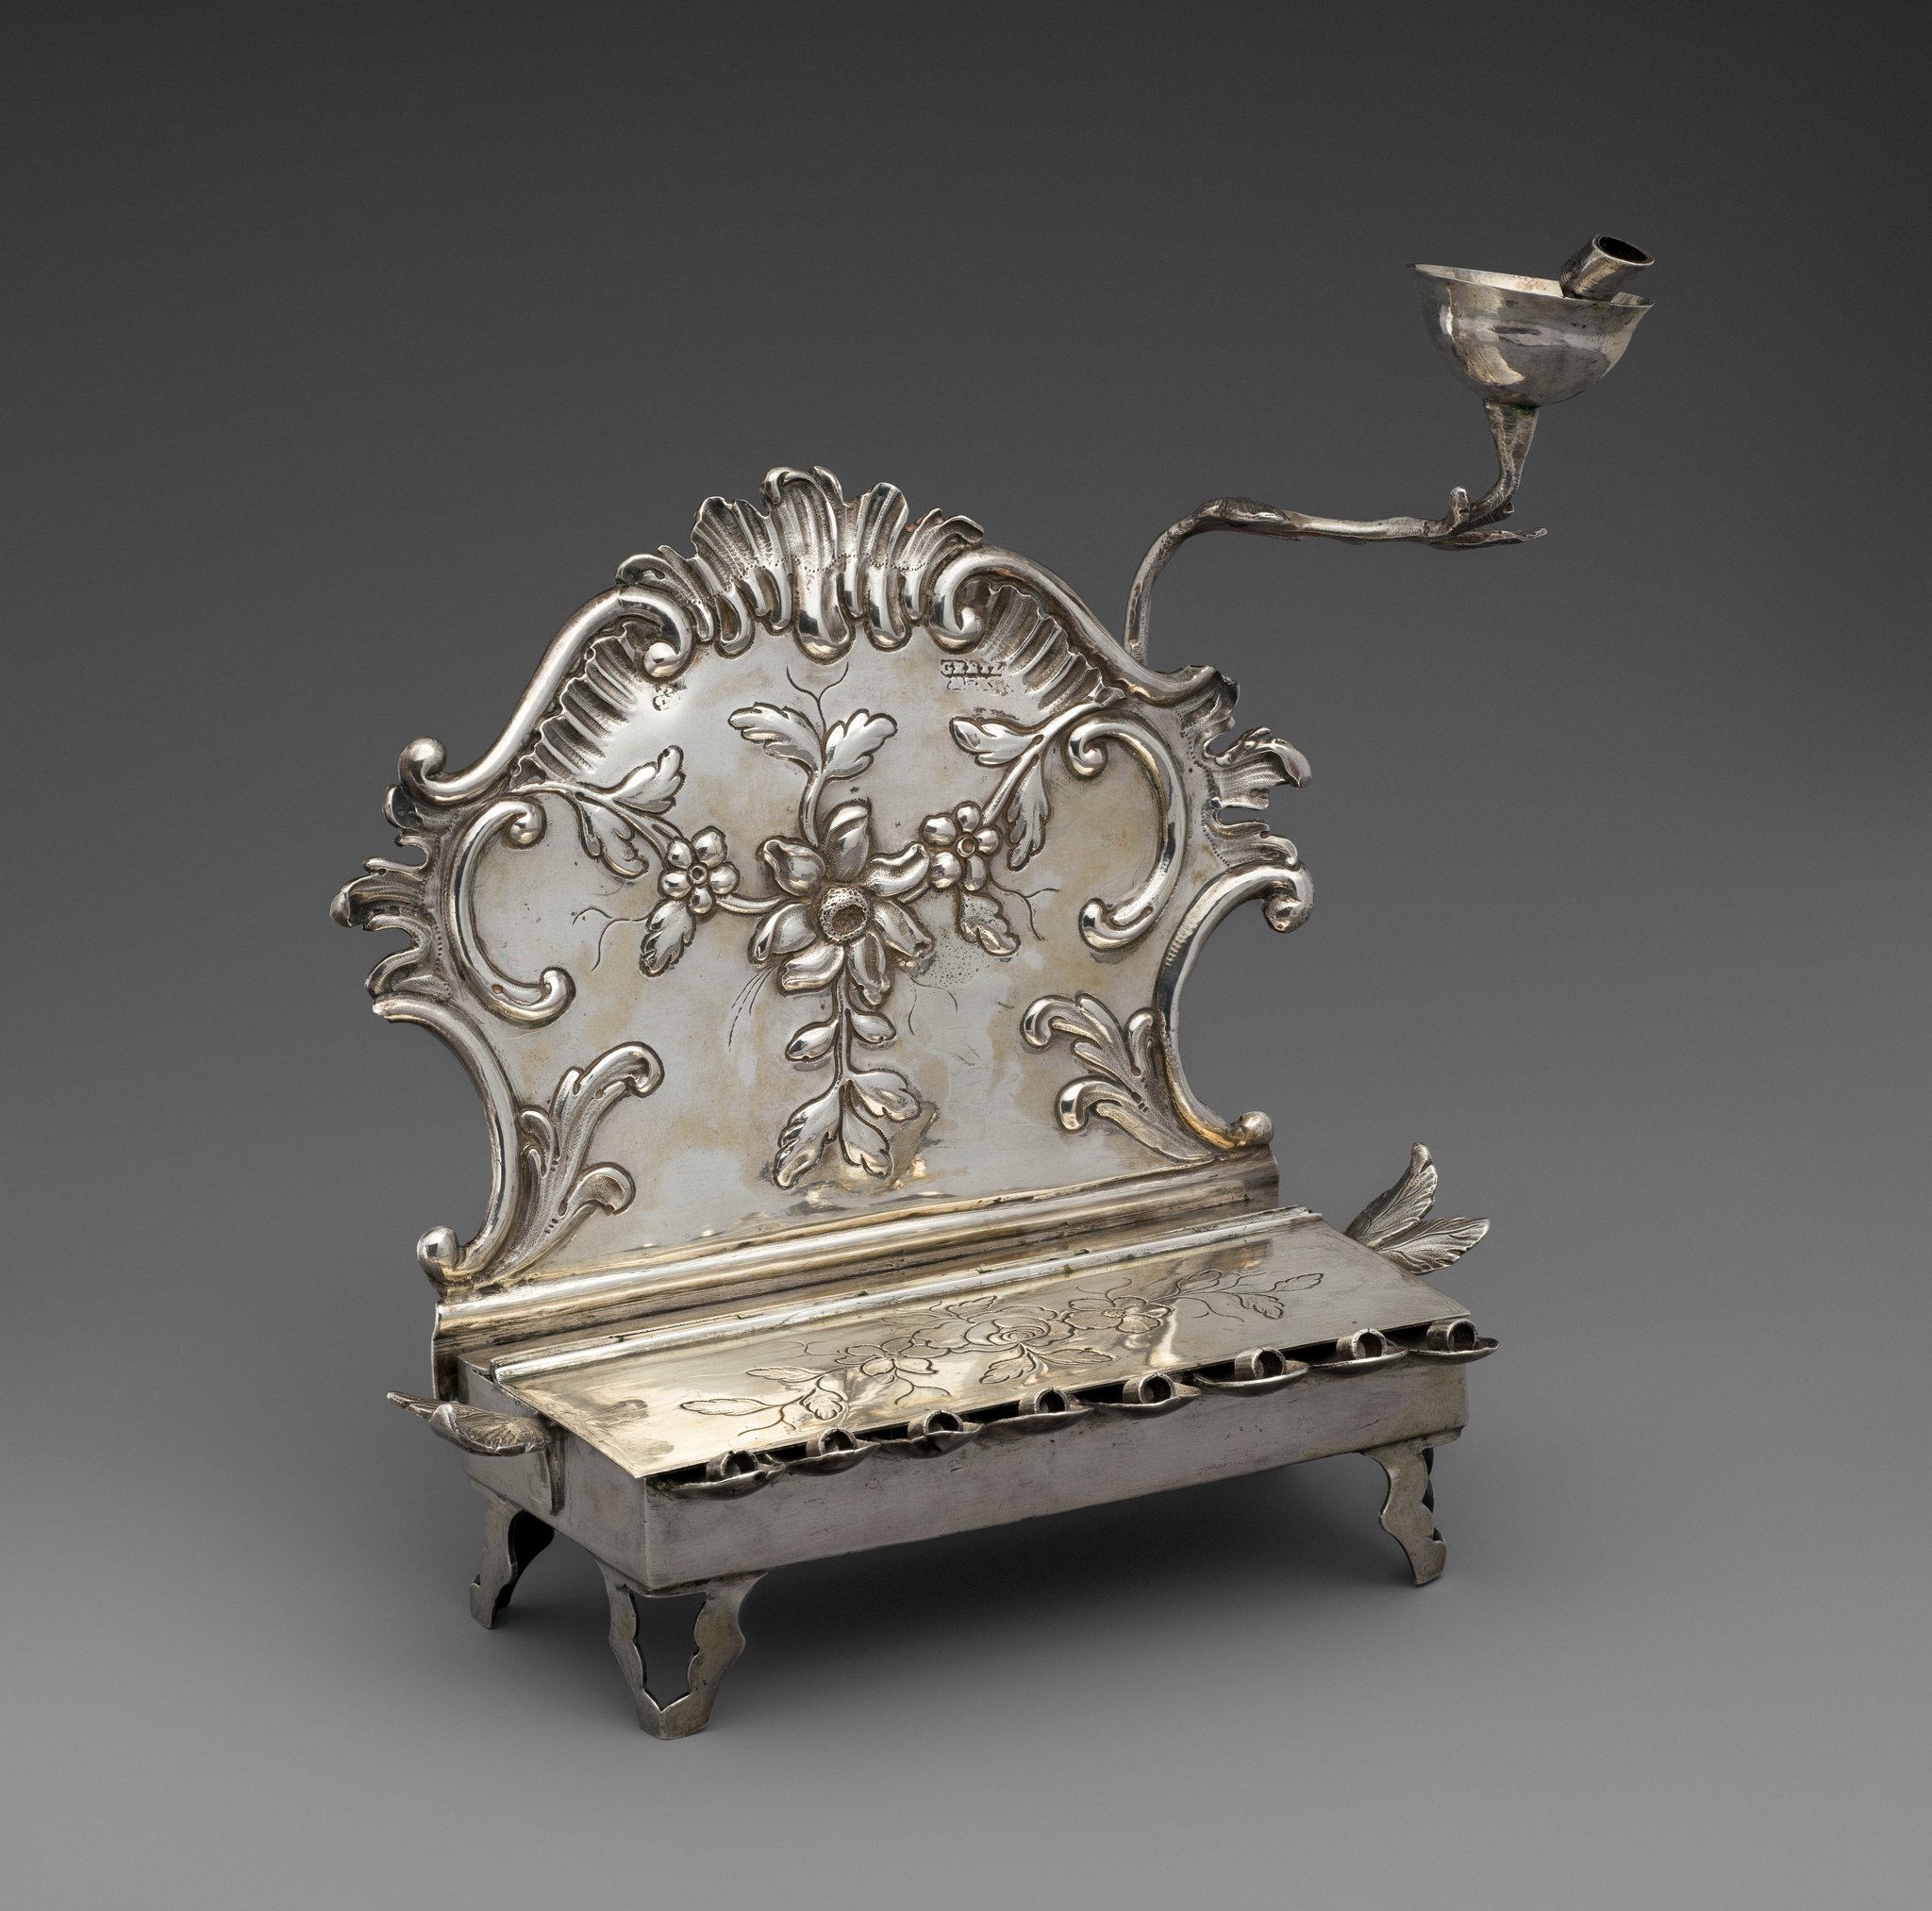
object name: hanukkah lamp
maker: august ferdinand gentzmer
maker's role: maker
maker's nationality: german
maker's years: 1758-1808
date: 1788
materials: silver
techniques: embossing